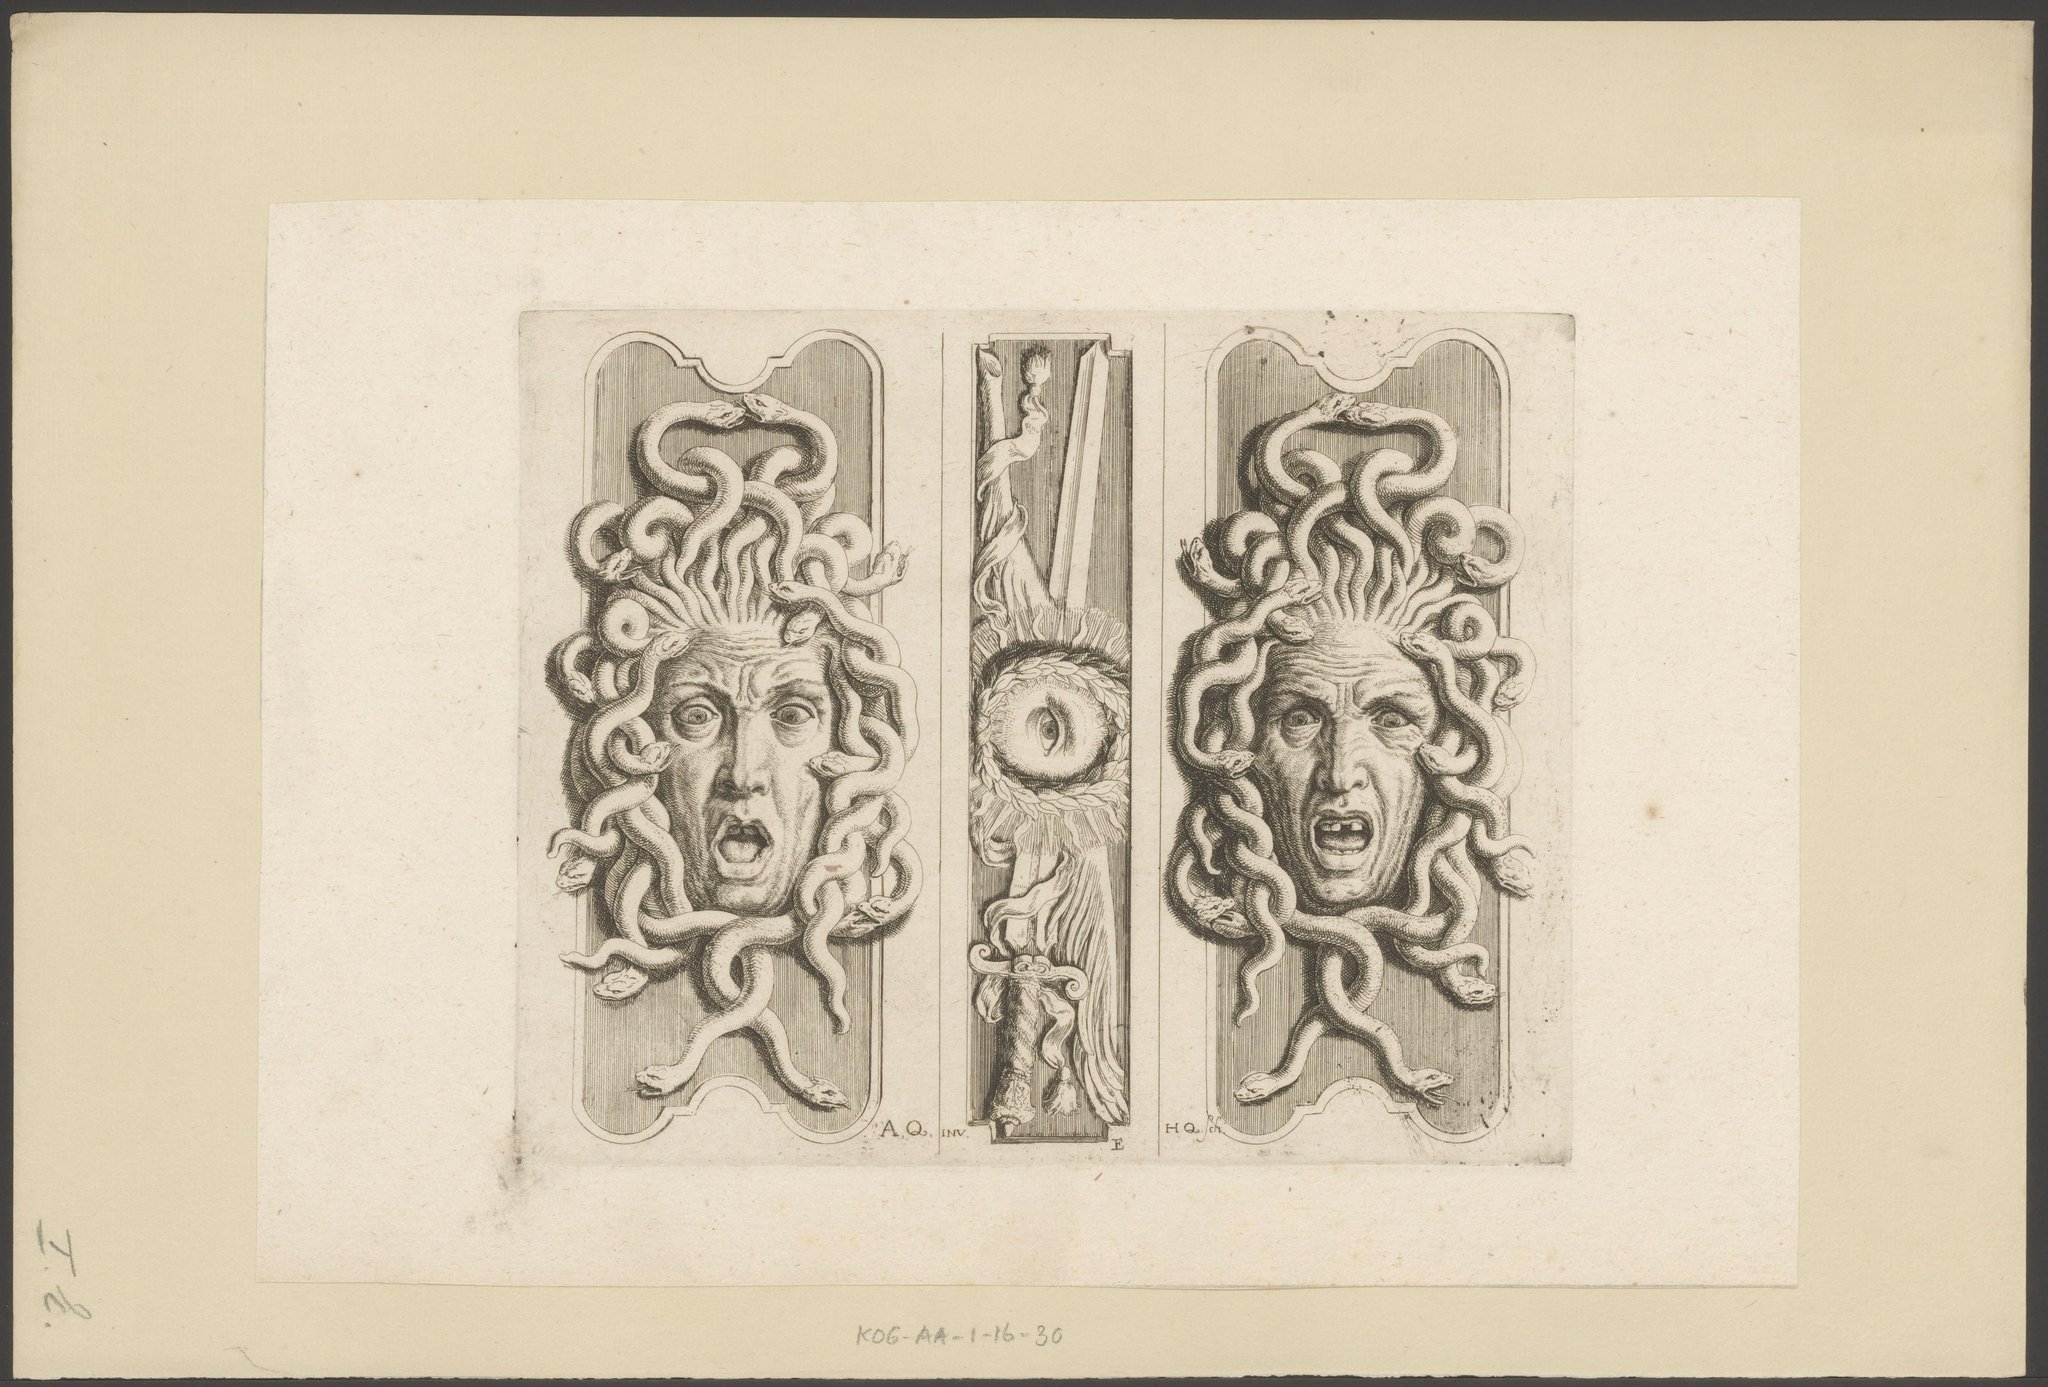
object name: print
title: Ornamenten met Medusakoppen en het alziend oog uit de Vierschaar van het Stadhuis op de Dam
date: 1655-1665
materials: paper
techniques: engraving, etching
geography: amsterdam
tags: townhall, the all-seeing eye, triangle with eye ~ symbol of god the father, gorgoneion, head of medusa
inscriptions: collector's mark: ‘16,30’ Lugt 1641b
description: Prent gebruikt in: Prima pars. Praecipuarum effigierum ac ornamentorum, amplissimae Curiae Amstelrodamensis (…) / Het eerste deel. Van de voornaemste Statuen ende Ciraten, vant konstijck Stadhuys van Amstelredam, tmeeste in marmer gemaeckt, door Artus Quellinus, Beelthouwer der voorseyde Stadt / La Premier Partie. De plusieurs Figures et ornements, de la Maison de Ville d'Amsterdam (…). Amsterdam: Artus Quellinus (I), 1655. Zie RP-P-AO-22-1-1 voor bijhorende titelpagina. Zie RP-P-AO-22-1-2 voor bijhorend register. Zie RP-P-AO-22-1A, RP-P-AO-22-1B, RP-P-AO-22-1C, RP-P-AO-22-1D-1, RP-P-AO-22-1D-2, RP-P-AO-22-1F, RP-P-AO-22-1G, RP-P-AO-22-1H, RP-P-AO-22-1I, RP-P-AO-22-1K-1, RP-P-AO-22-1K-2, RP-P-AO-22-1K-3, RP-P-AO-22-1K-4, RP-P-AO-22-1K-5, RP-P-AO-22-1L-1, RP-P-AO-22-1L-2, RP-P-AO-22-1M-1, RP-P-AO-22-1M-2, RP-P-AO-22-1N-1, RP-P-AO-22-1N-2, RP-P-AO-22-1N-3, RP-P-AO-22-1N-4, RP-P-AO-22-1N-5, RP-P-AO-22-1O-1, RP-P-AO-22-1O-2, RP-P-AO-22-1O-3, RP-P-AO-22-1O-4, RP-P-AO-22-1P-1, RP-P-AO-22-1P-2, RP-P-AO-22-1P-3, RP-P-AO-22-1P-4, RP-P-AO-22-1Q-1, RP-P-AO-22-1Q-2, RP-P-AO-22-1Q-3, RP-P-AO-22-1Q-4, RP-P-AO-22-1R-1, RP-P-AO-22-1R-2, RP-P-AO-22-1R-3, RP-P-AO-22-1R-4, RP-P-AO-22-1R-5, RP-P-AO-22-1S-1, RP-P-AO-22-1S-2, RP-P-AO-22-1S-3, RP-P-AO-22-1S-4, RP-P-AO-22-1S-5, RP-P-AO-22-1T-1 en RP-P-AO-22-1T-2 voor andere prenten uit deze publicatie. Zelfde staat van prent ook gebruikt in: Prima pars. Praecipuarum effigierum ac ornamentorum, amplissimae Curiae Amstelrodamensis (…) / Het eerste deel. Van de voornaemste Statuen ende Ciraten, vant konstijck Stadhuys van Amstelredam, tmeeste in marmer gemaeckt, door Artus Quellinus, Beelthouwer der voorseyde Stadt / La Premier Partie. De plusieurs Figures et ornements, de la Maison de Ville d'Amsterdam (…). Amsterdam: Frederik de Wit, 1665. Latere staat van prent ook gebruikt in: Architecture peinture et sculpture de la Maison de Ville d'Amsterdam, representee en CIX. figures en taille-douce (…). Amsterdam: David Mortier, 1719. En in: Architecture peinture et sculpture de la Maison de Ville d'Amsterdam, representee en CIX. figures en taille-douce (…). Amsterdam: Gerard Valck, 1719. En in: Bouw schilder en beeldhouwkonst, van het Stadhuis te Amsteldam, vertoont in CIX figuuren (…). Amsterdam: Covens & Mortier & Covens Jr., s.a. (1774-1783).